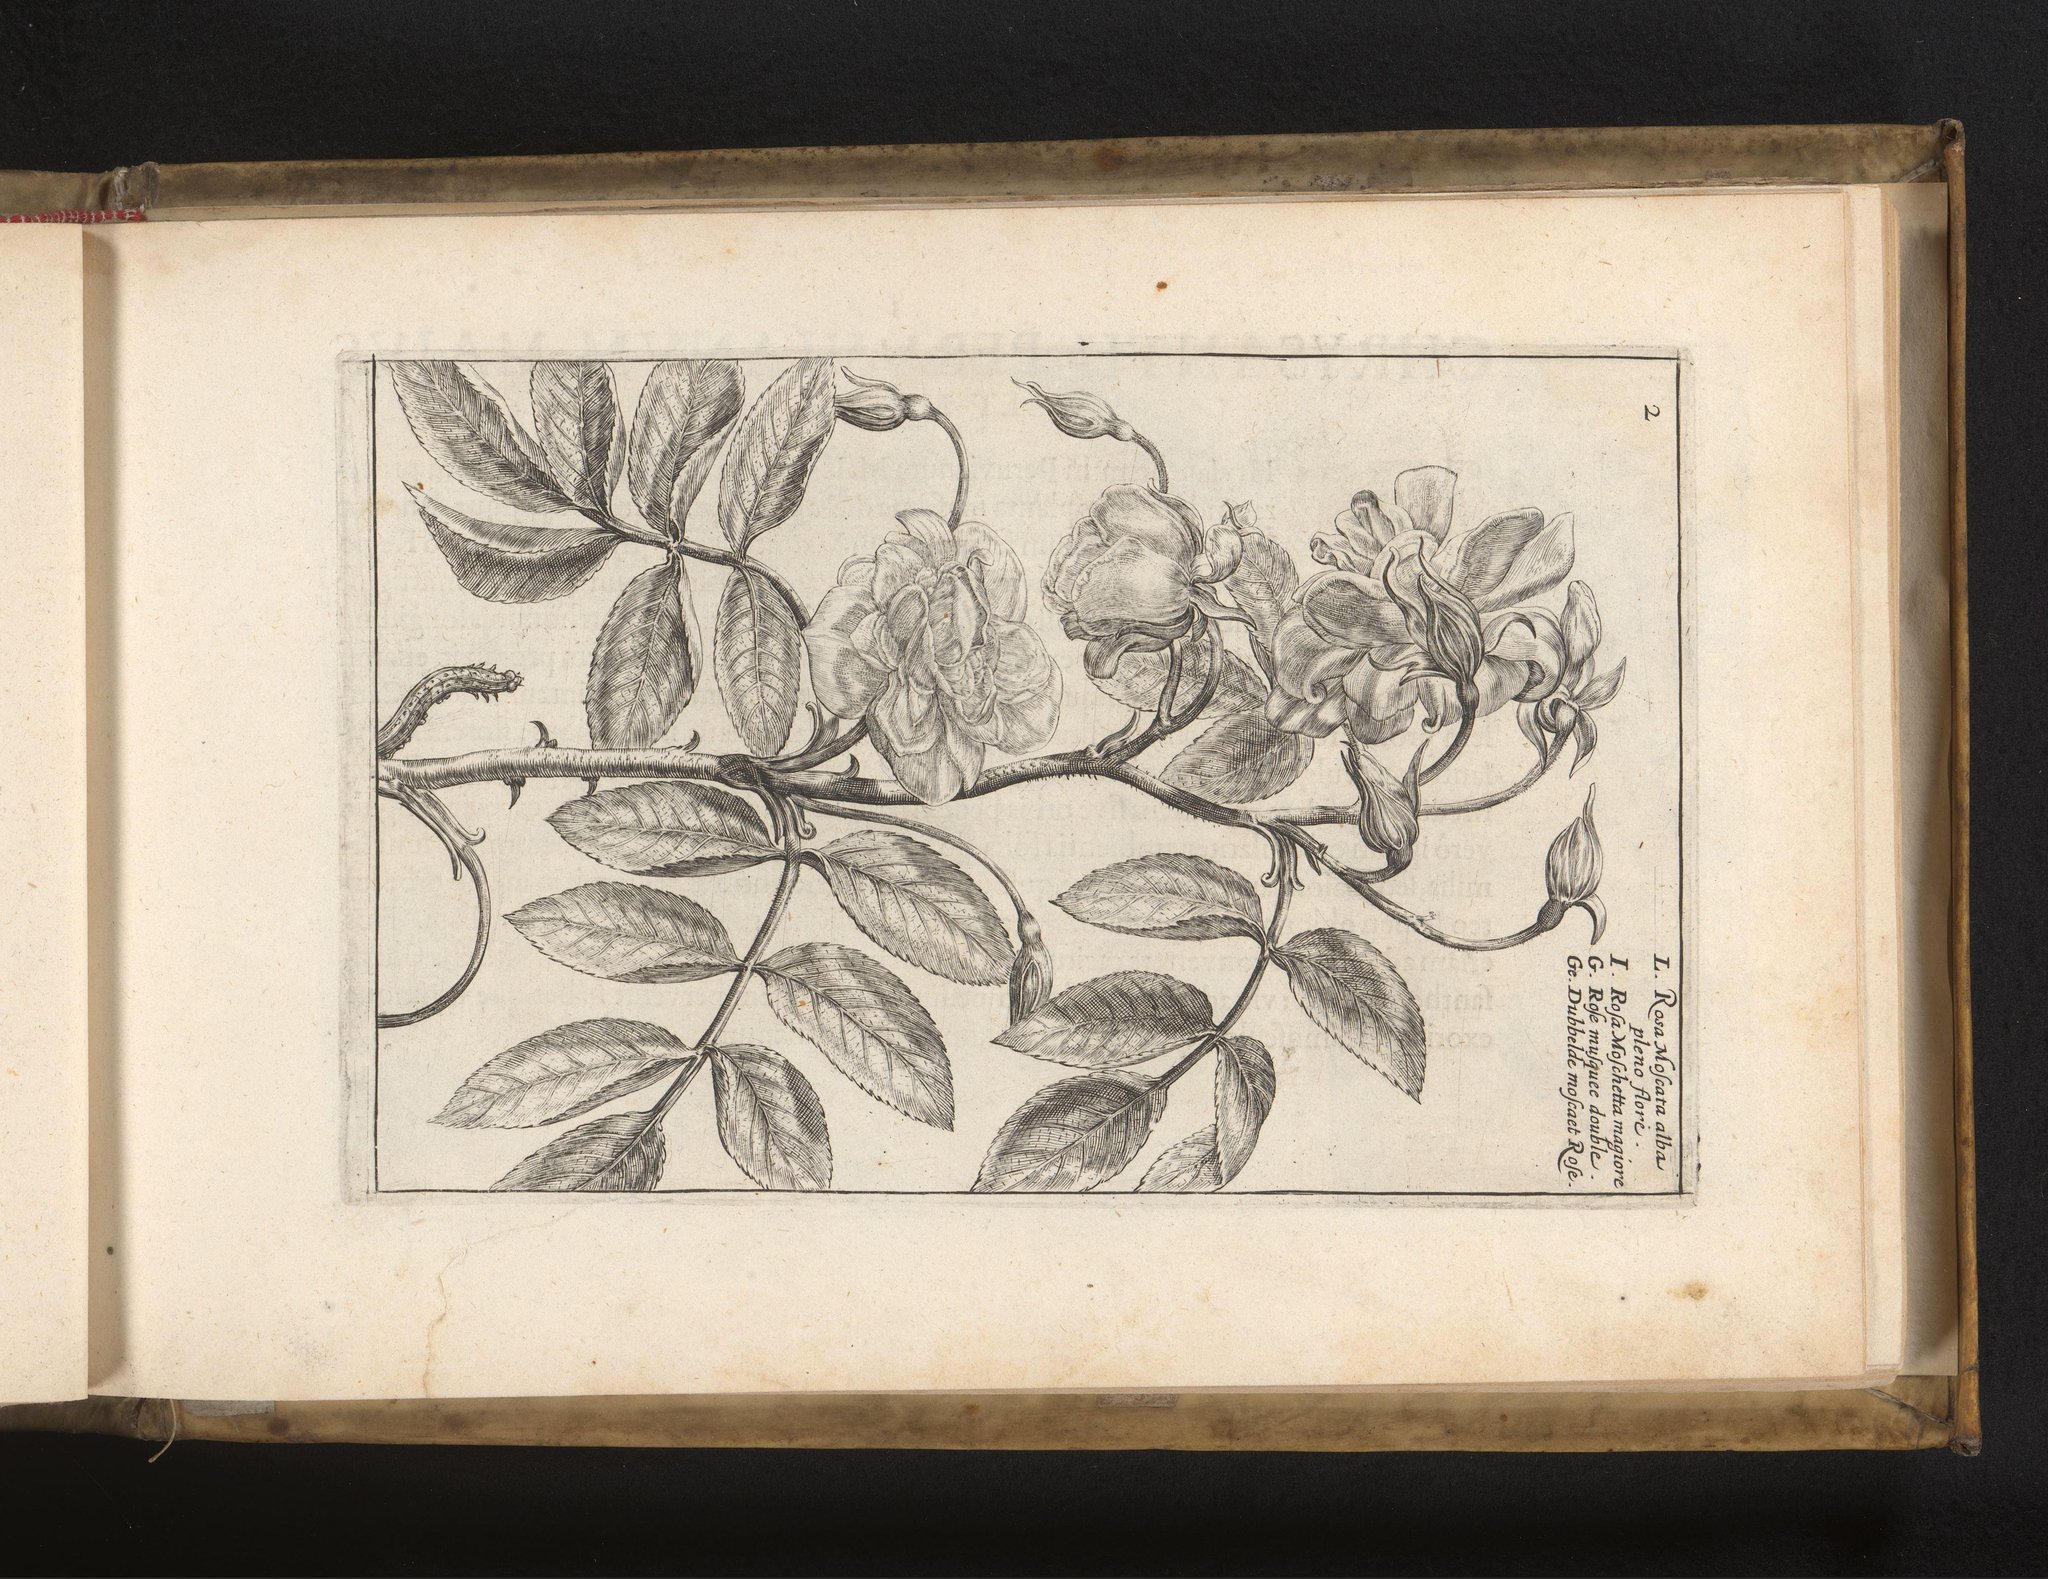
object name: page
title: Rosa moscata alba pleno flore / Rosa moschetta magiore / Rose musquee double / Dubbelde moscaet rose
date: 1617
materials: paper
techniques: engraving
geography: arnhem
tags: flowers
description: Prent uit: Passe, Crispijn van de (II). Hortus floridus in quo rariorum & minus vulgarium florum icones ad vivam veramque formam. Arnhem: Johannes Janssonius, 1617.